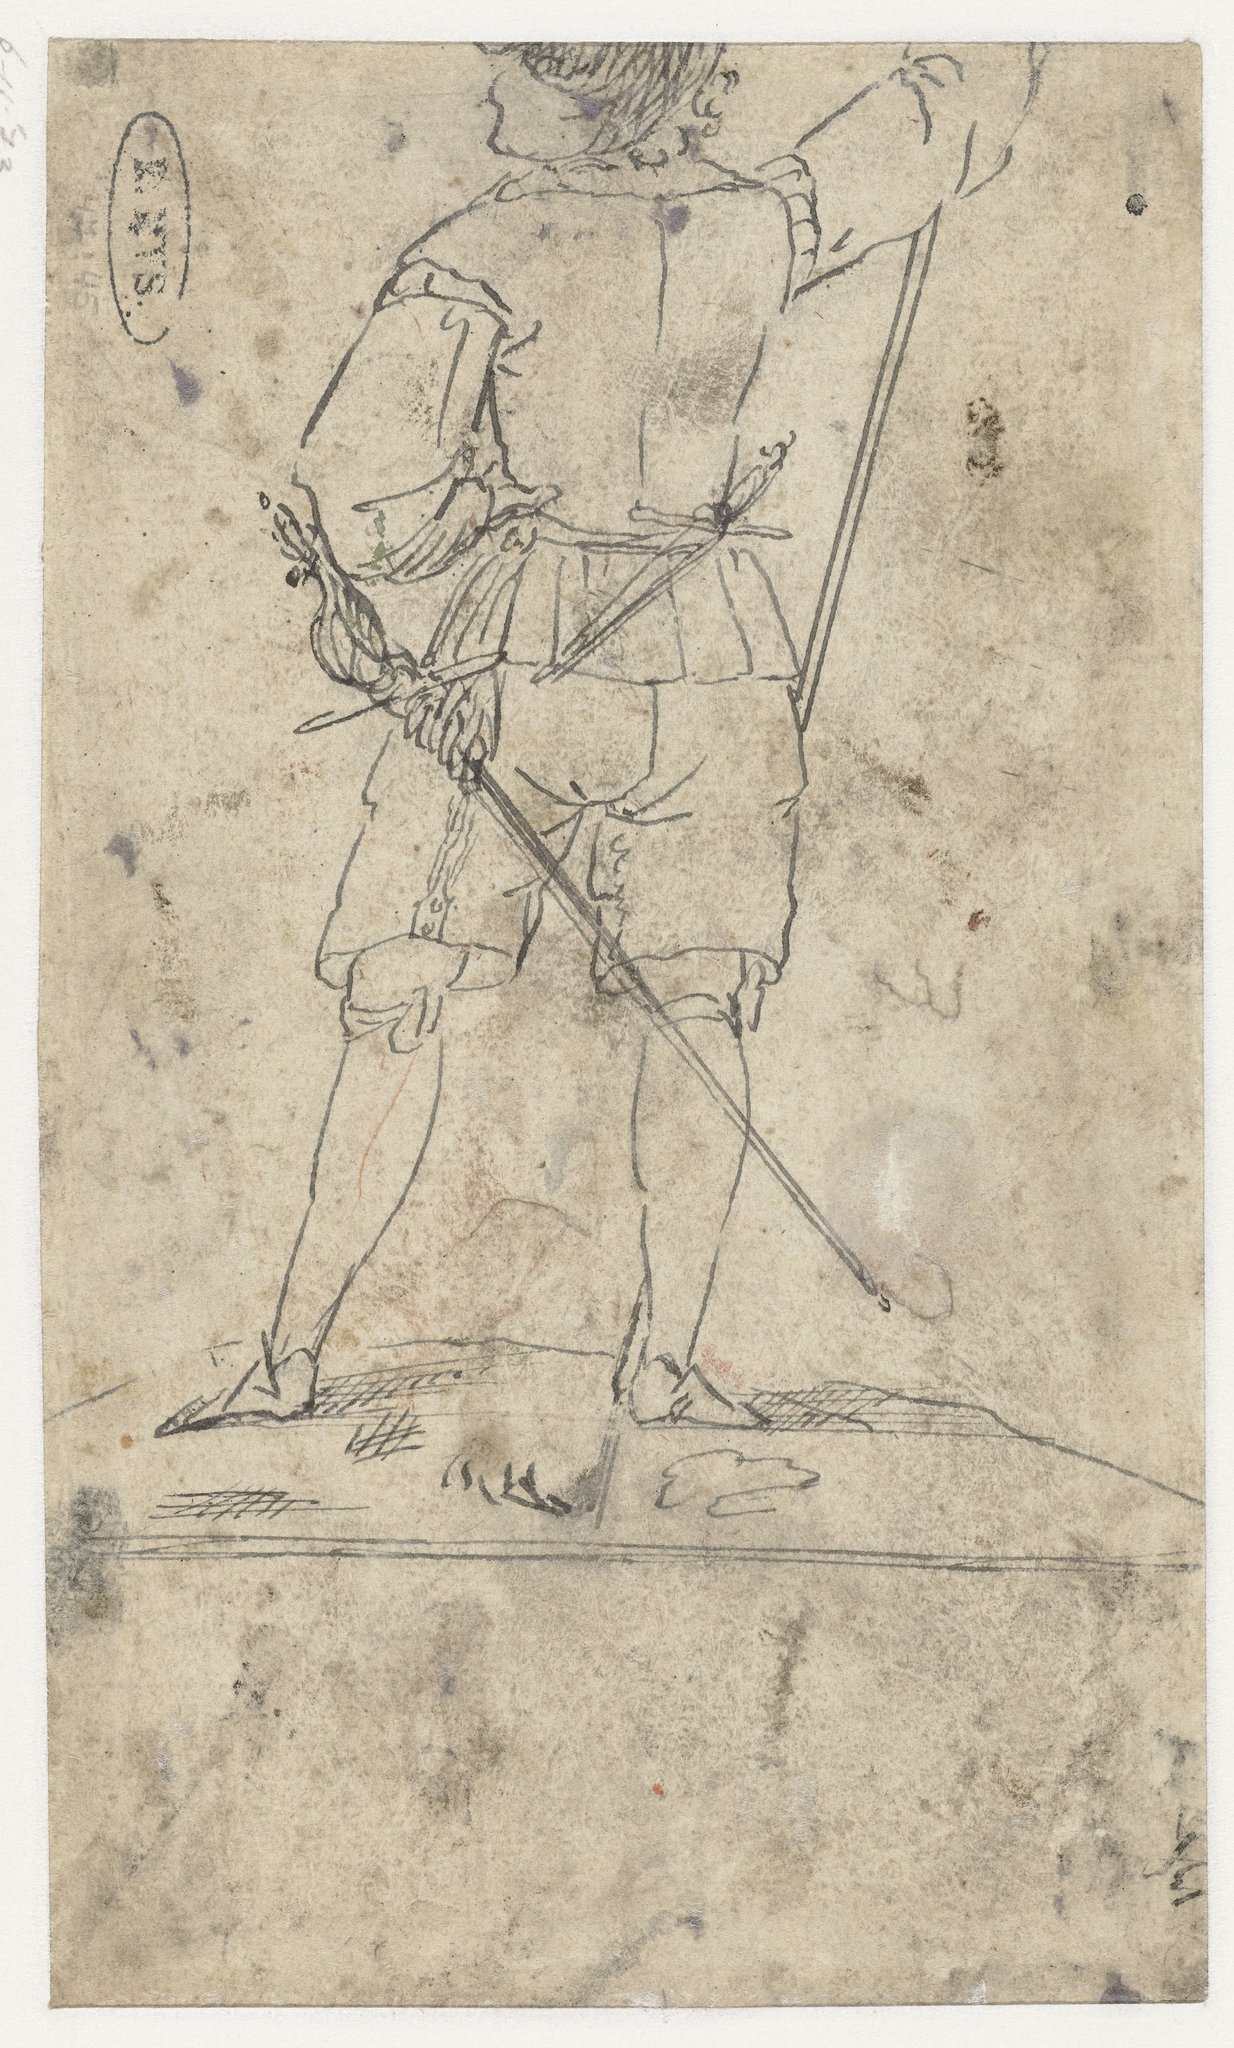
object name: drawing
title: Studie van een staande soldaat, op de rug gezien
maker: Anonymous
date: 1599-1649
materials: ink, paper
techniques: pen